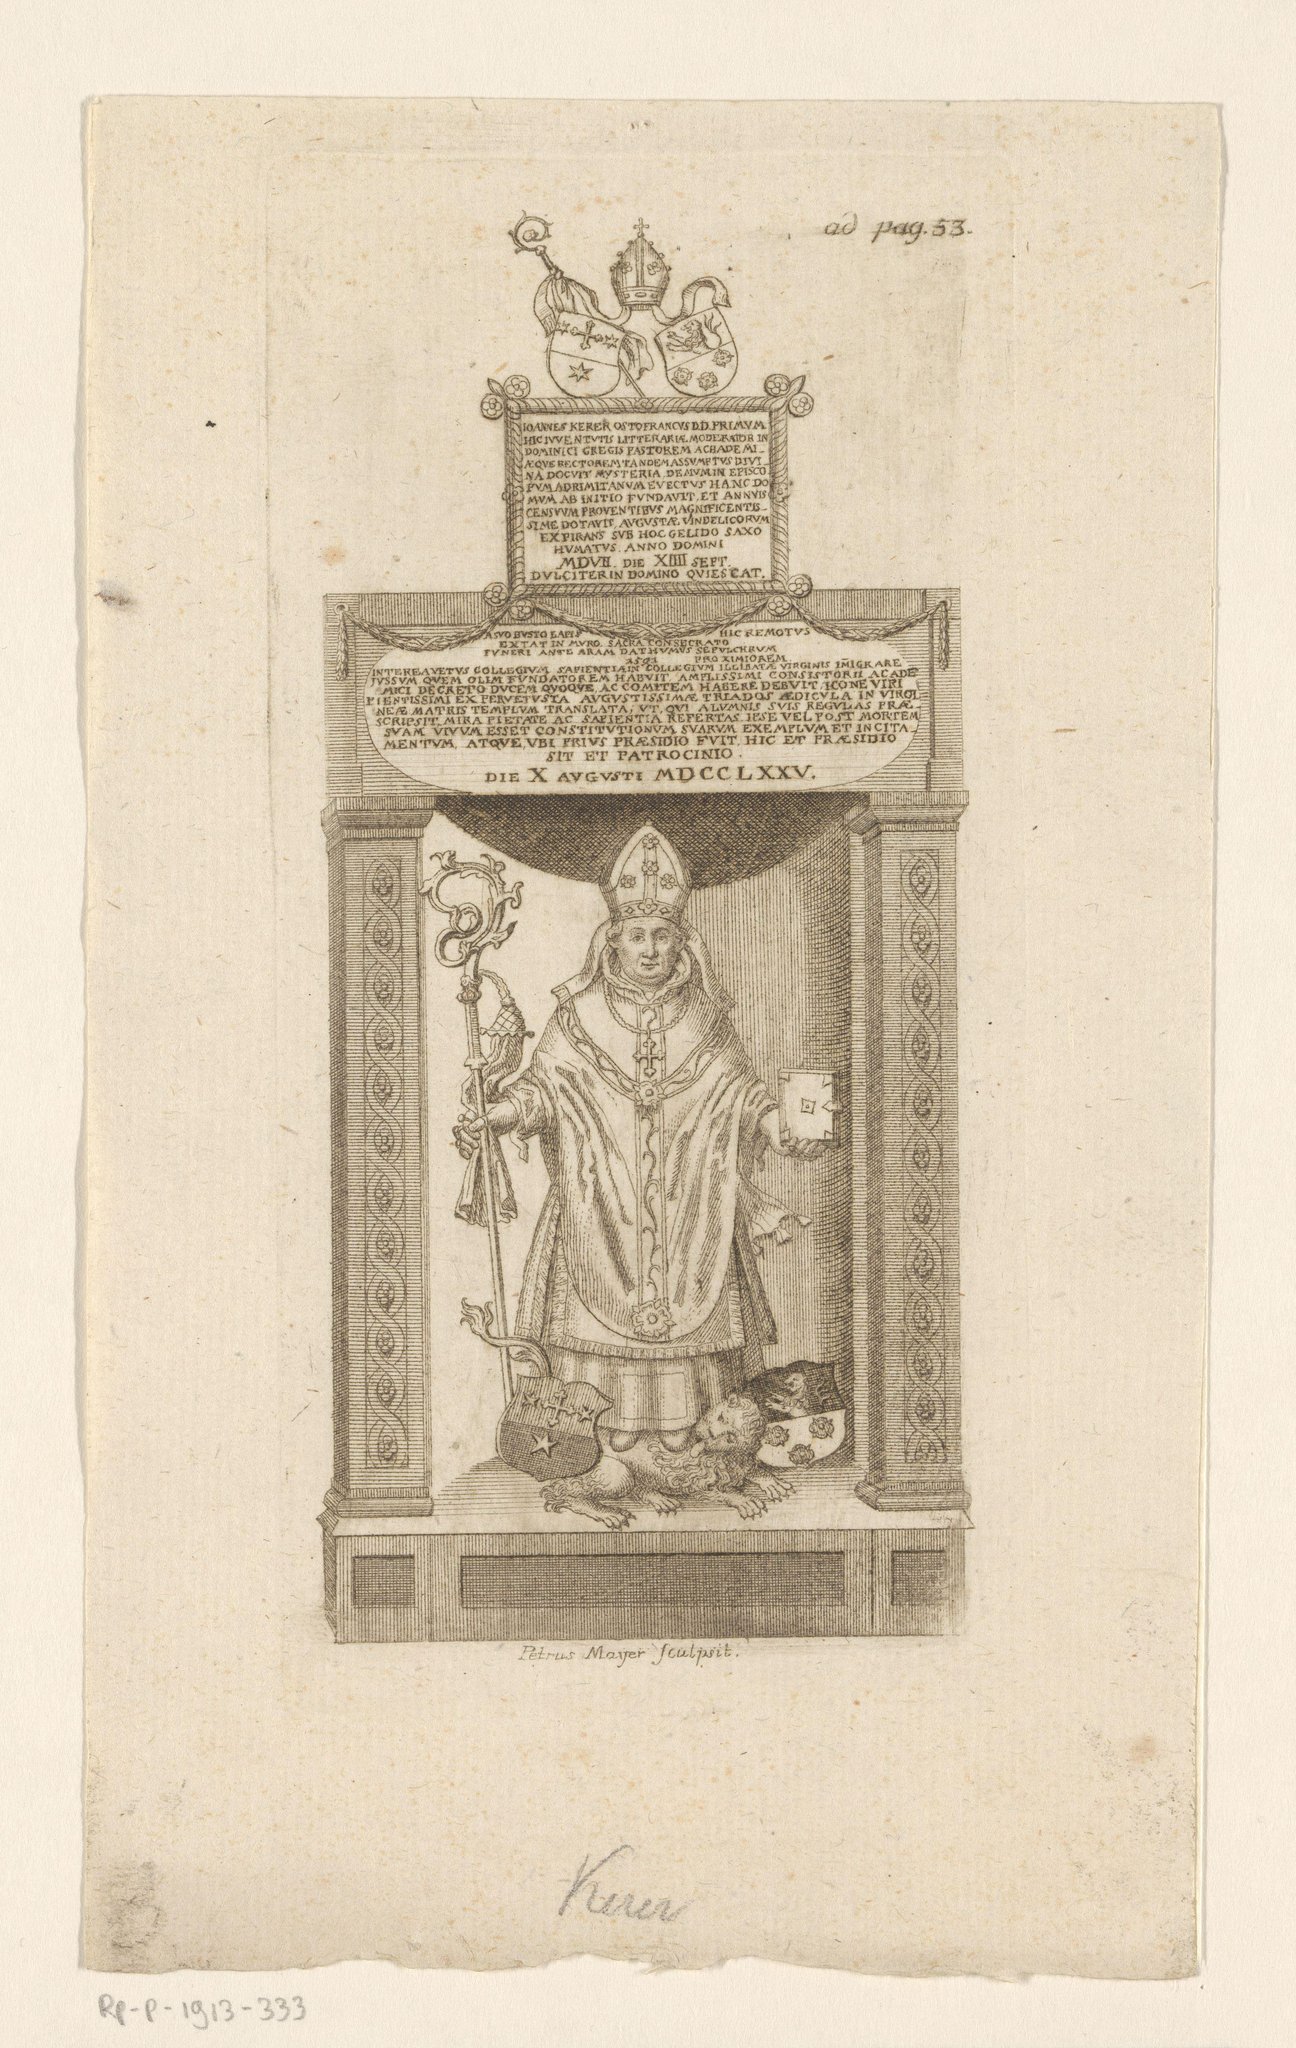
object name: print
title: Grafmonument van Johannes Kerer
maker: peter mayr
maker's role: painter, print maker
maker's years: 1758-1836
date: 1768-1836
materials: paper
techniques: engraving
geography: freiburg im breisgau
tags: augsburg, insignia of bishop, e.g. mitre, crozier, historical persons, grave-building, monumental tomb, armorial bearing, heraldry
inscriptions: collector's mark: Lugt 2228